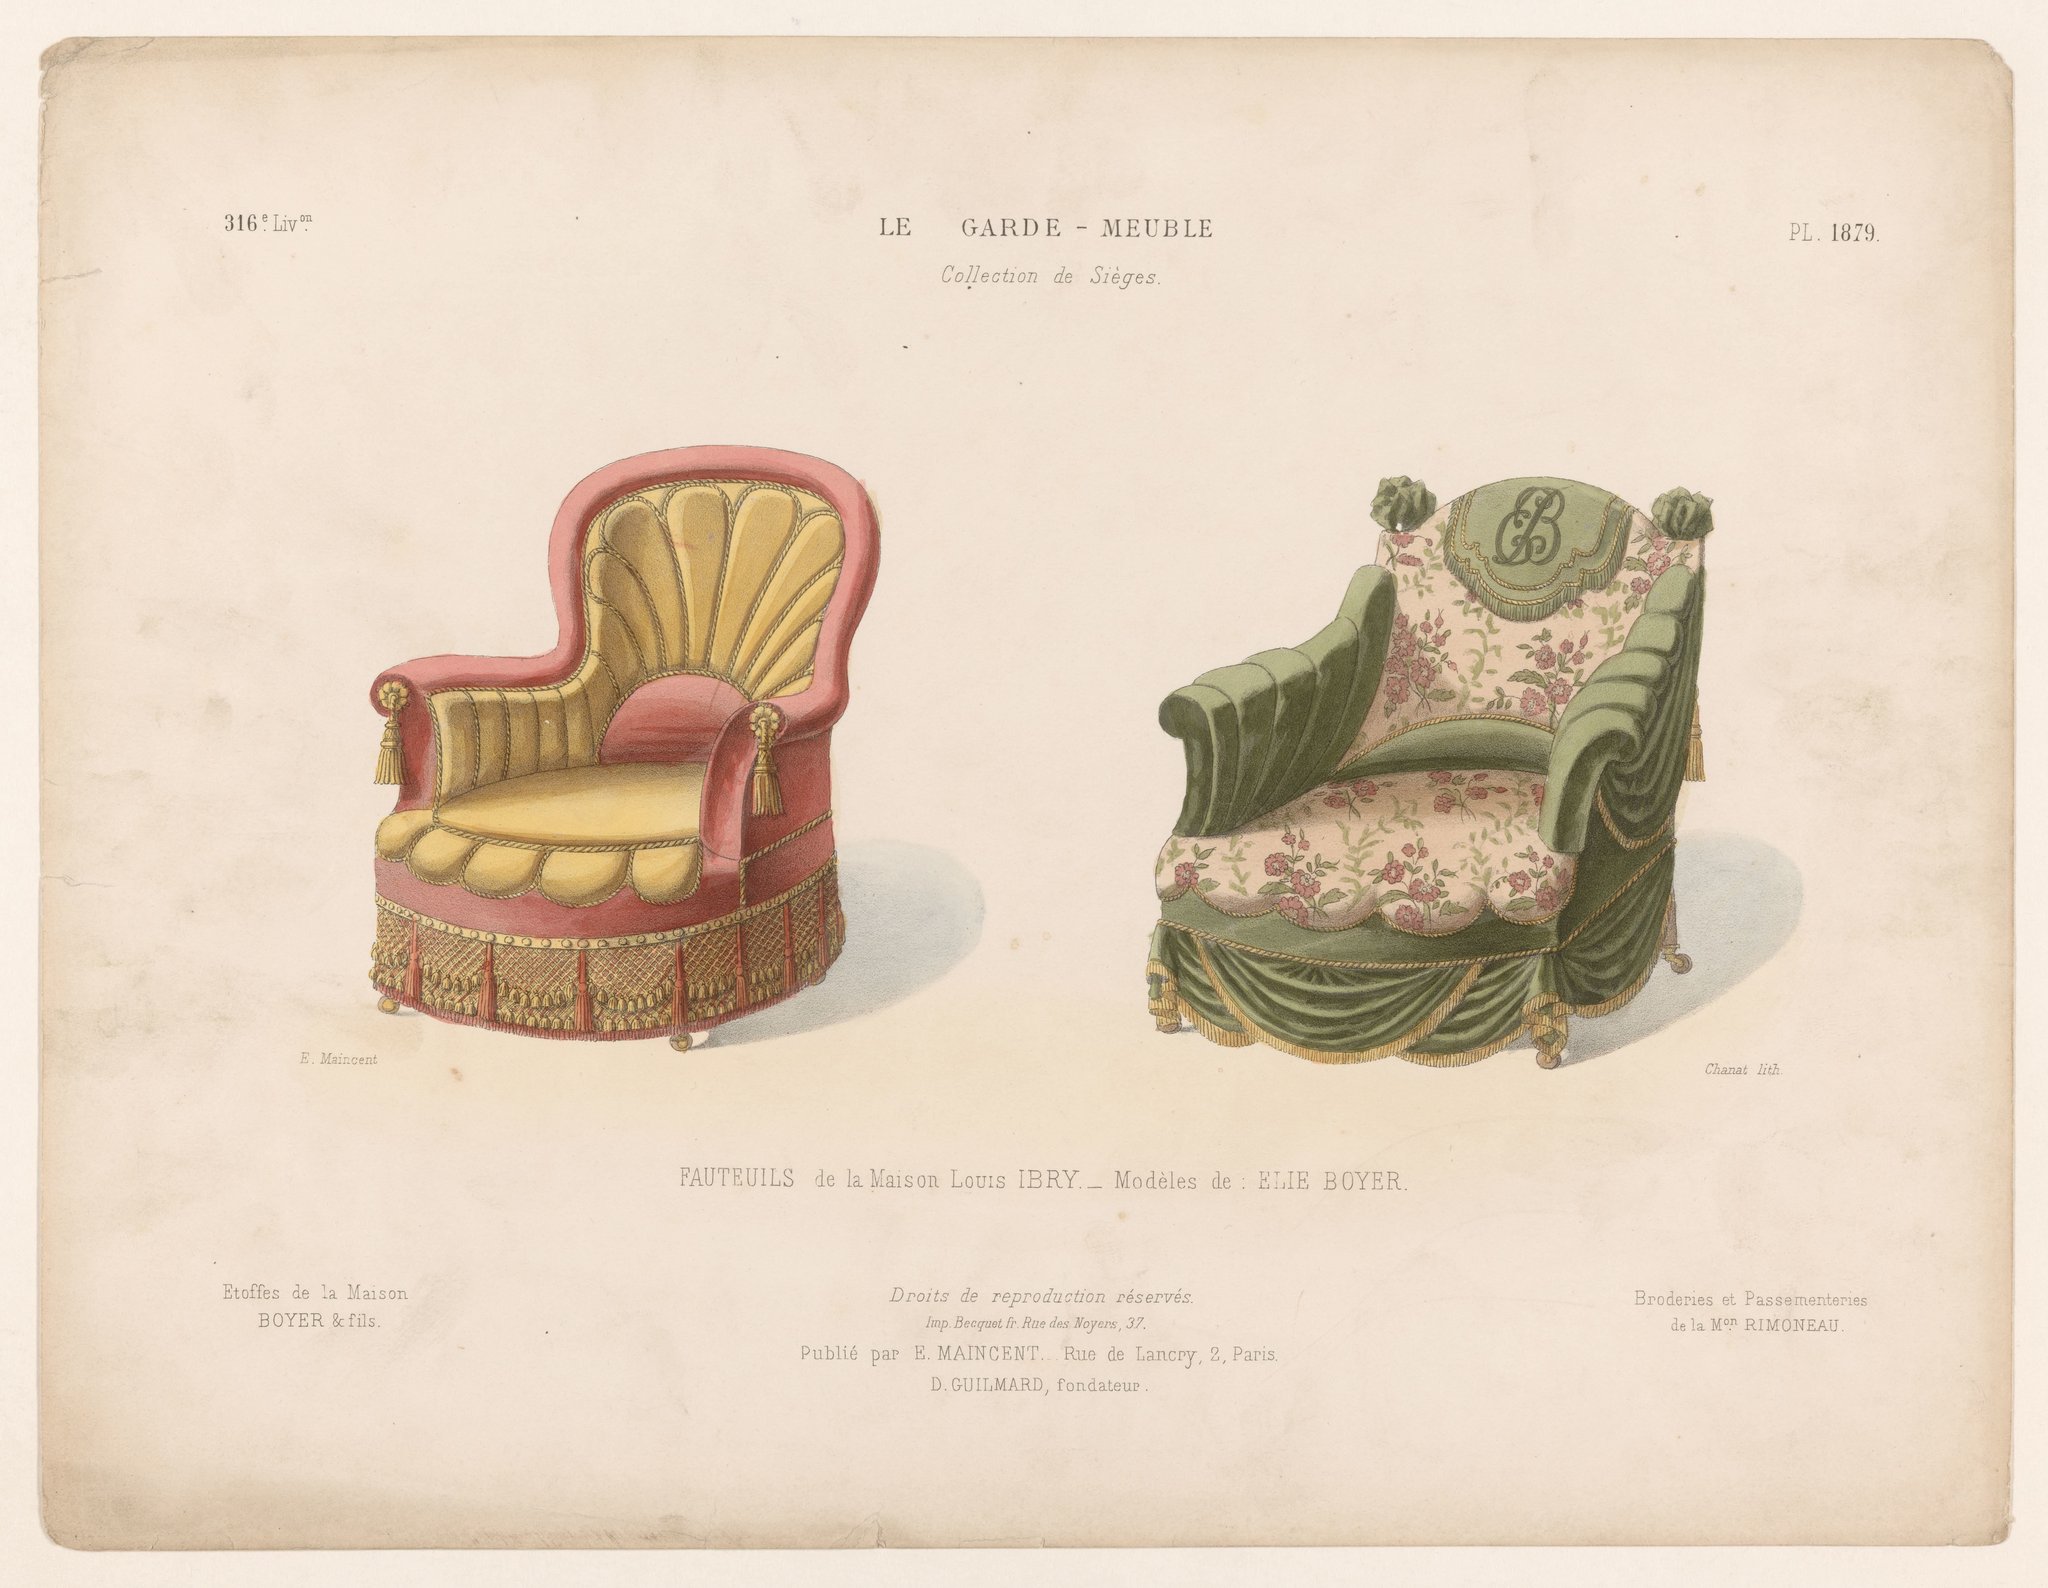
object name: print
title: Twee fauteuils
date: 1885-1895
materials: paper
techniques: hand coloring, lithograph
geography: paris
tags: seating furniture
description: Ieder Livraison in de serie Le Garde-Meuble bevat negen platen: drie 'sièges' (zitmeubels), drie 'meubles' (diverse meubels zoals tafels en kasten) en drie 'tentures' (gordijnen en draperieën).